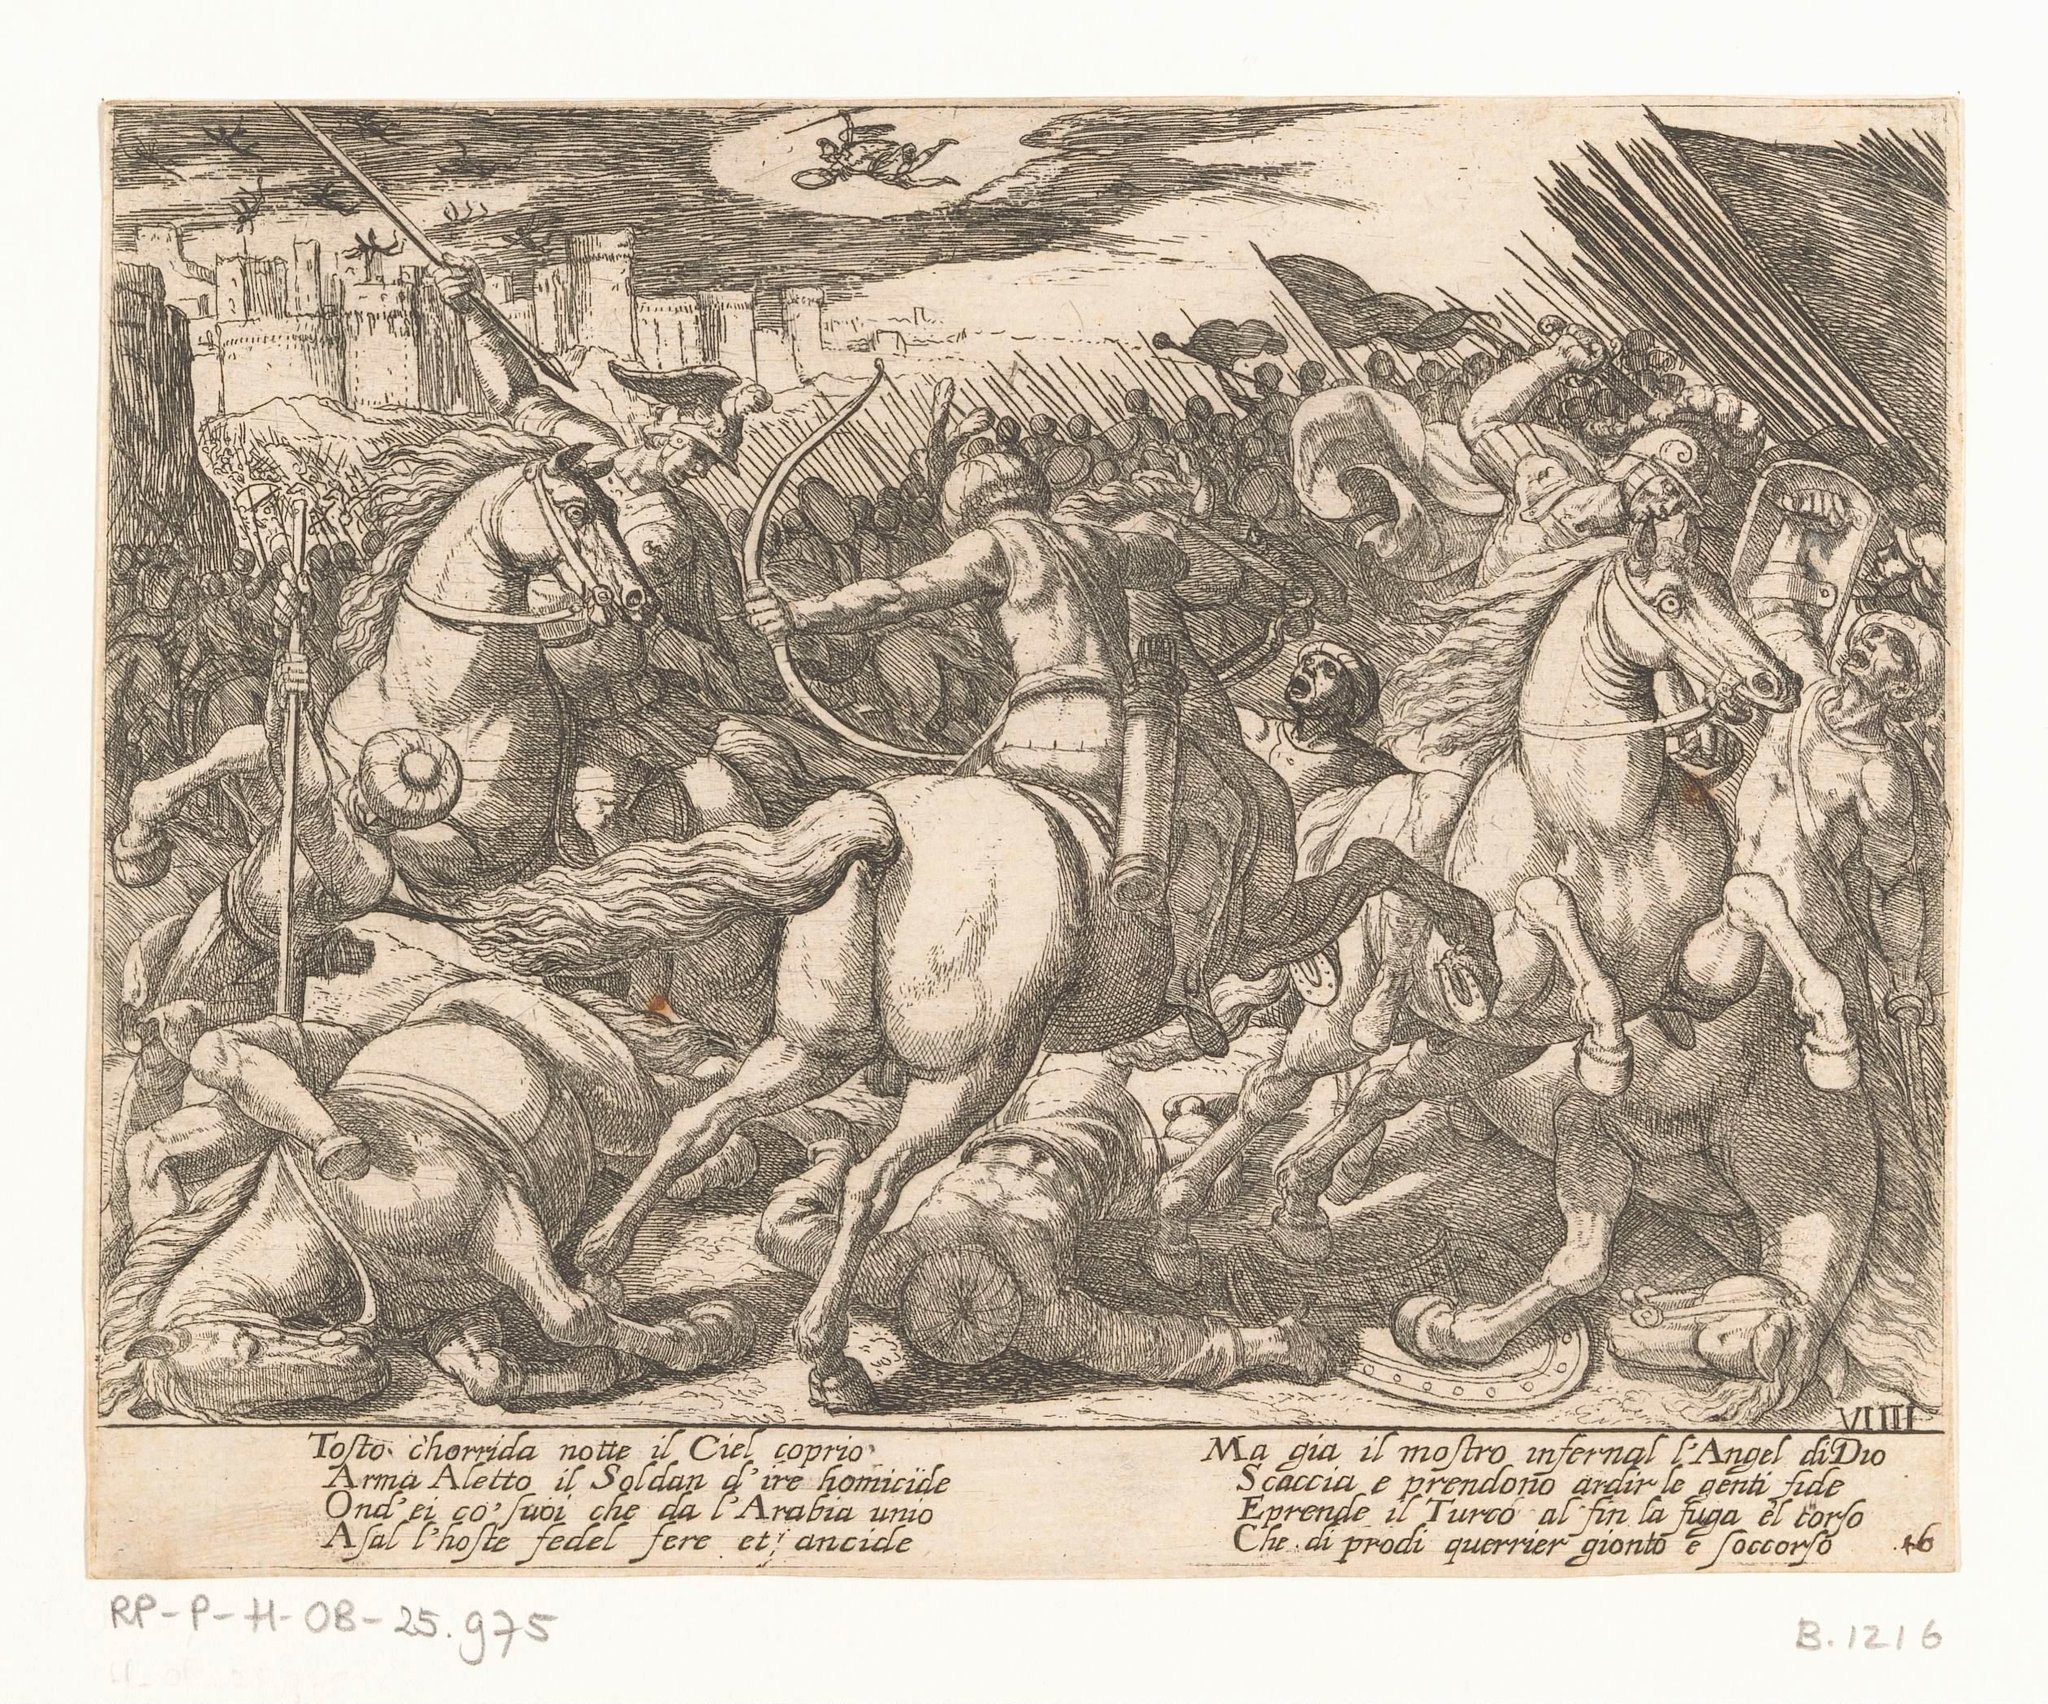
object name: print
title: Illustratie bij Canto IX van Tasso's 'Gerusalemme Liberata'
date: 1565-1630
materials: paper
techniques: etching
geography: vatican city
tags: the archangel michael (often in armour with sword or lance), battle, warfare; military affairs (+ cavalry, horsemen), militant proselytizing: religious war, crusade, etc., (scenes from) specific works of literature: tasso, gerusalemme liberata, knight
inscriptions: number: ‘16’, collector's mark: ‘Hinloopen’, collector's mark: Lugt 11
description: Deze prent maakt deel uit van een reeks van twintig prenten (+ opdracht) met voorstellingen van scènes uit Tasso's 'Jeruzalem verlost', een episch gedicht geschreven door de Italiaanse dichter Torquato Tasso en voor het eerst gepubliceerd in 1581. Het verhaal vertelt grotendeels in fictie over de Eerste Kruistocht waarin de christenen, geleid door Godfried van Bouillon, de strijd aangaan met de moslims om het Beleg van Jeruzalem.